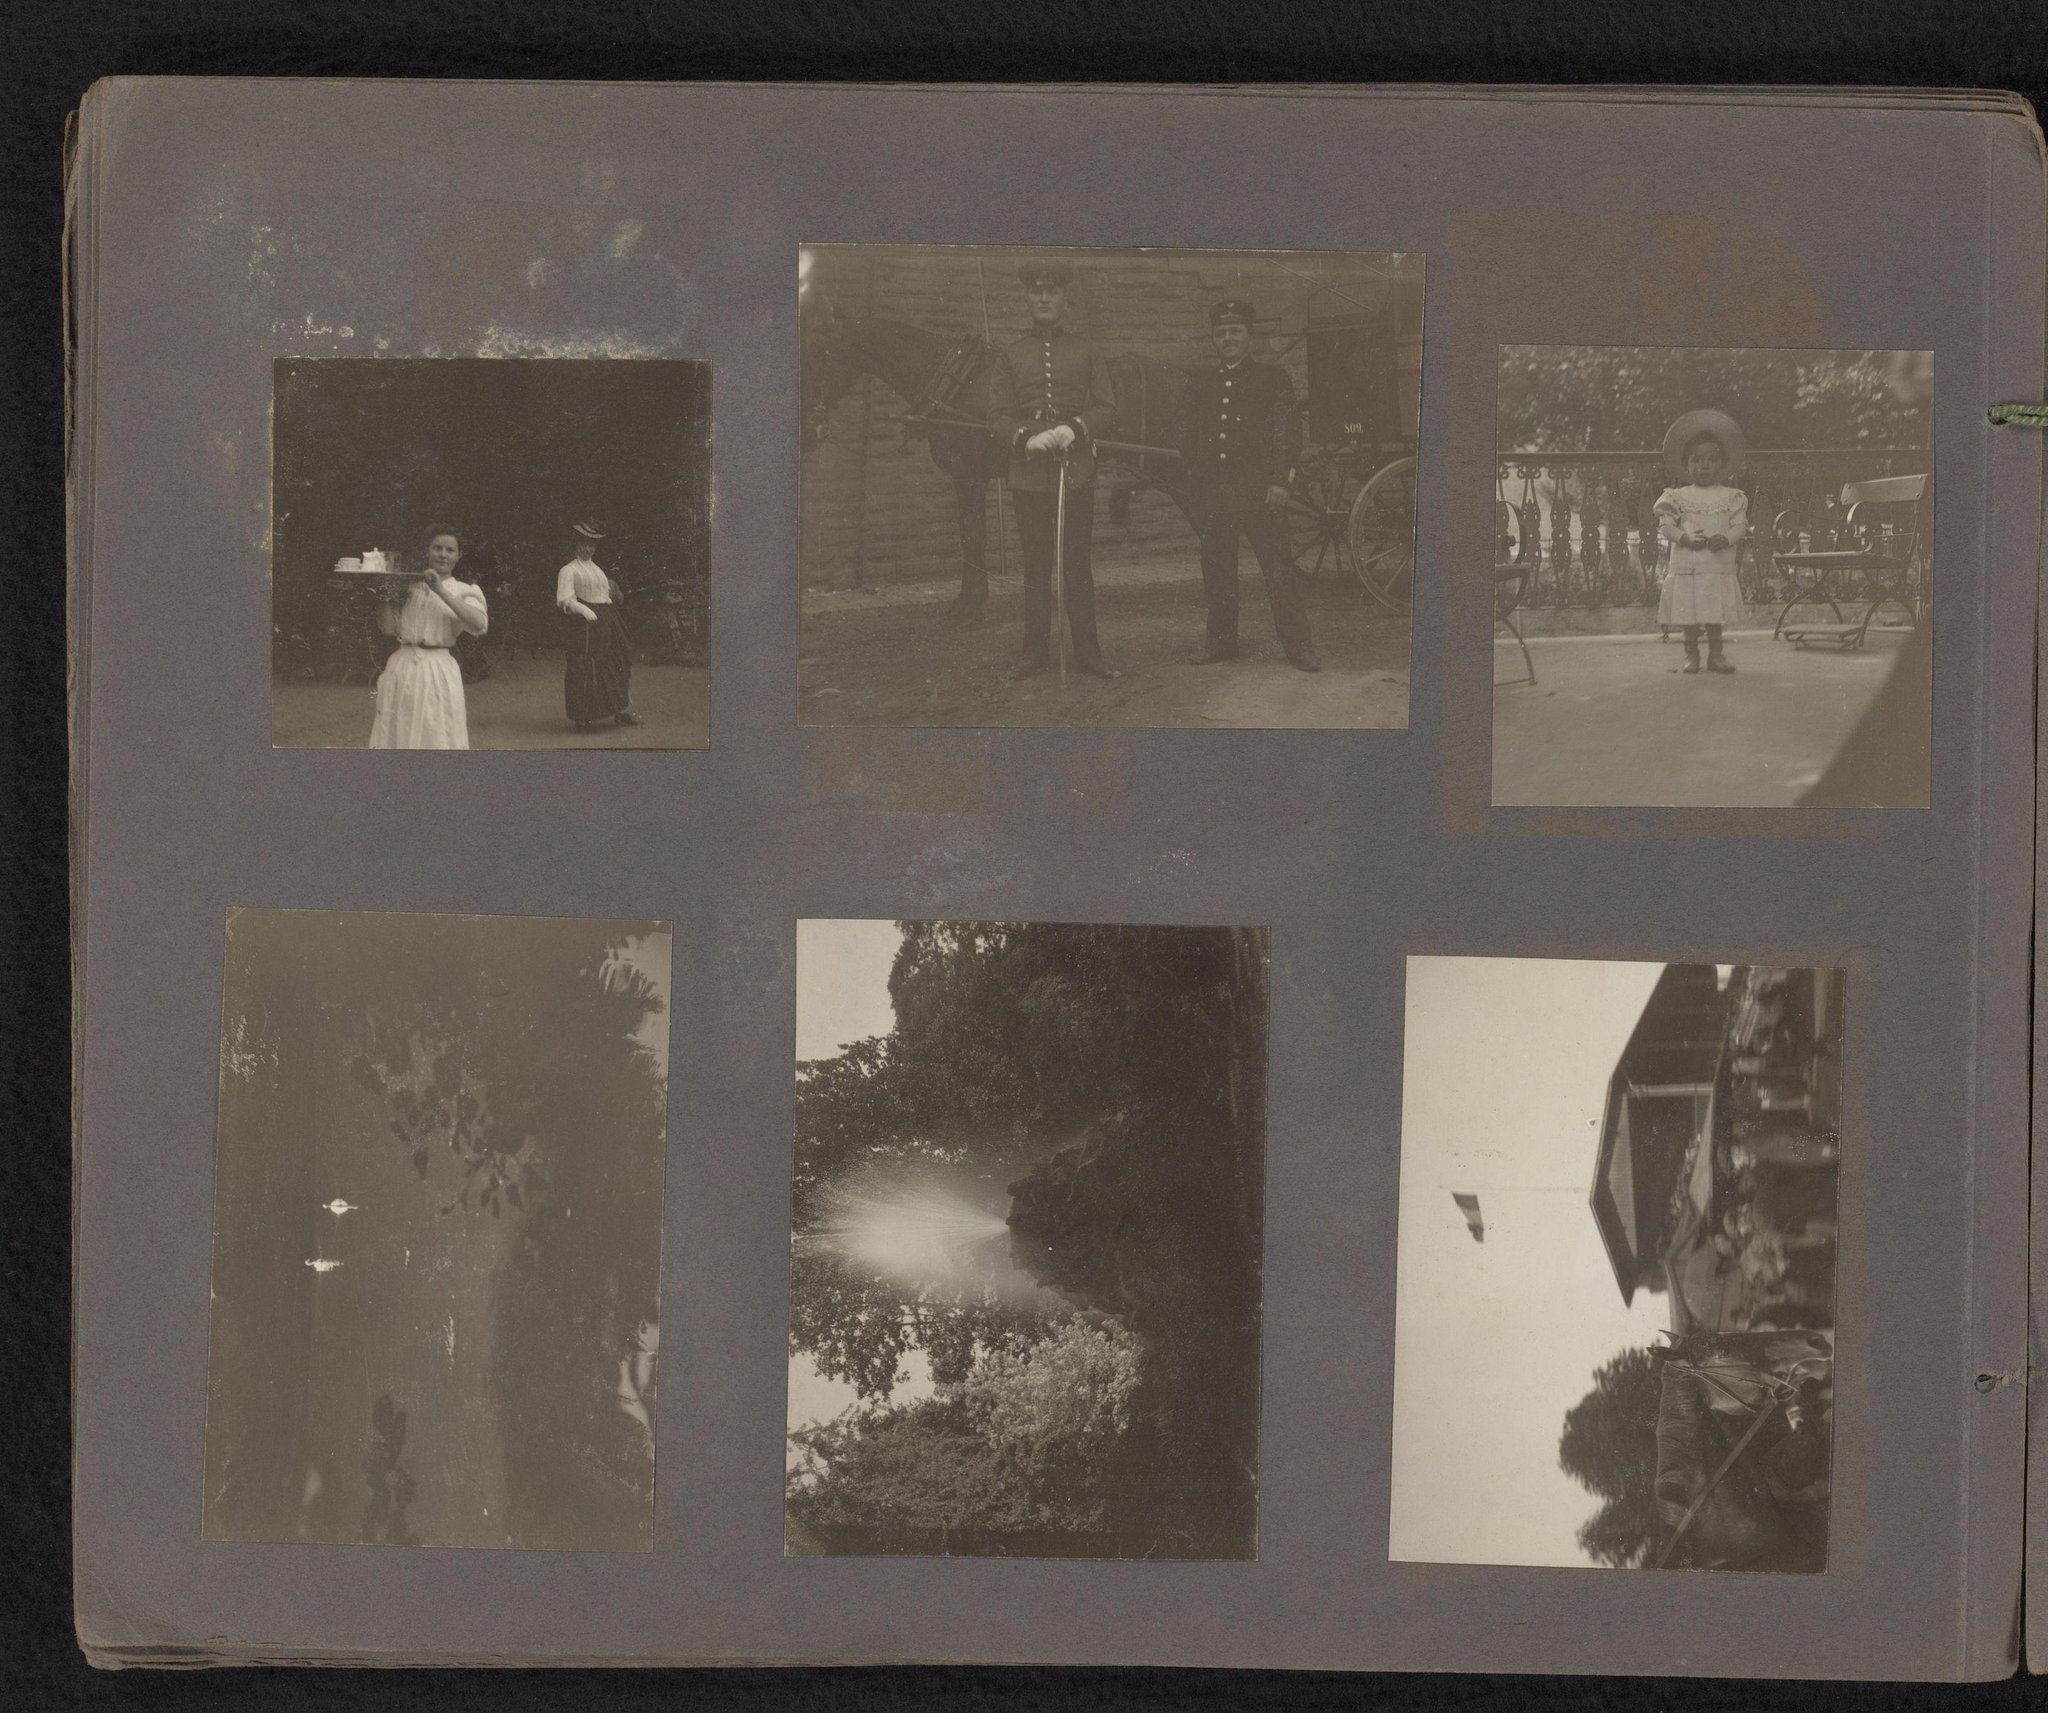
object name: photograph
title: Diverse onderwerpen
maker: Anonymous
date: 1905-1906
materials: cardboard, photographic support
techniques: gelatin silver print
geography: germany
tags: arthur moos, horse-racing, the soldier; the soldier's life, horse, germany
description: Albumblad met zes foto's met diverse onderwerpen: verschillende personen, vrouwen, kind, militairen, fontein en paardenrennen. Onderdeel van het fotoalbum van Arthur Moos tijdens zijn militaire diensttijd bij het 20e regiment Ulanen, Ludwigsburg, 1905-1906.